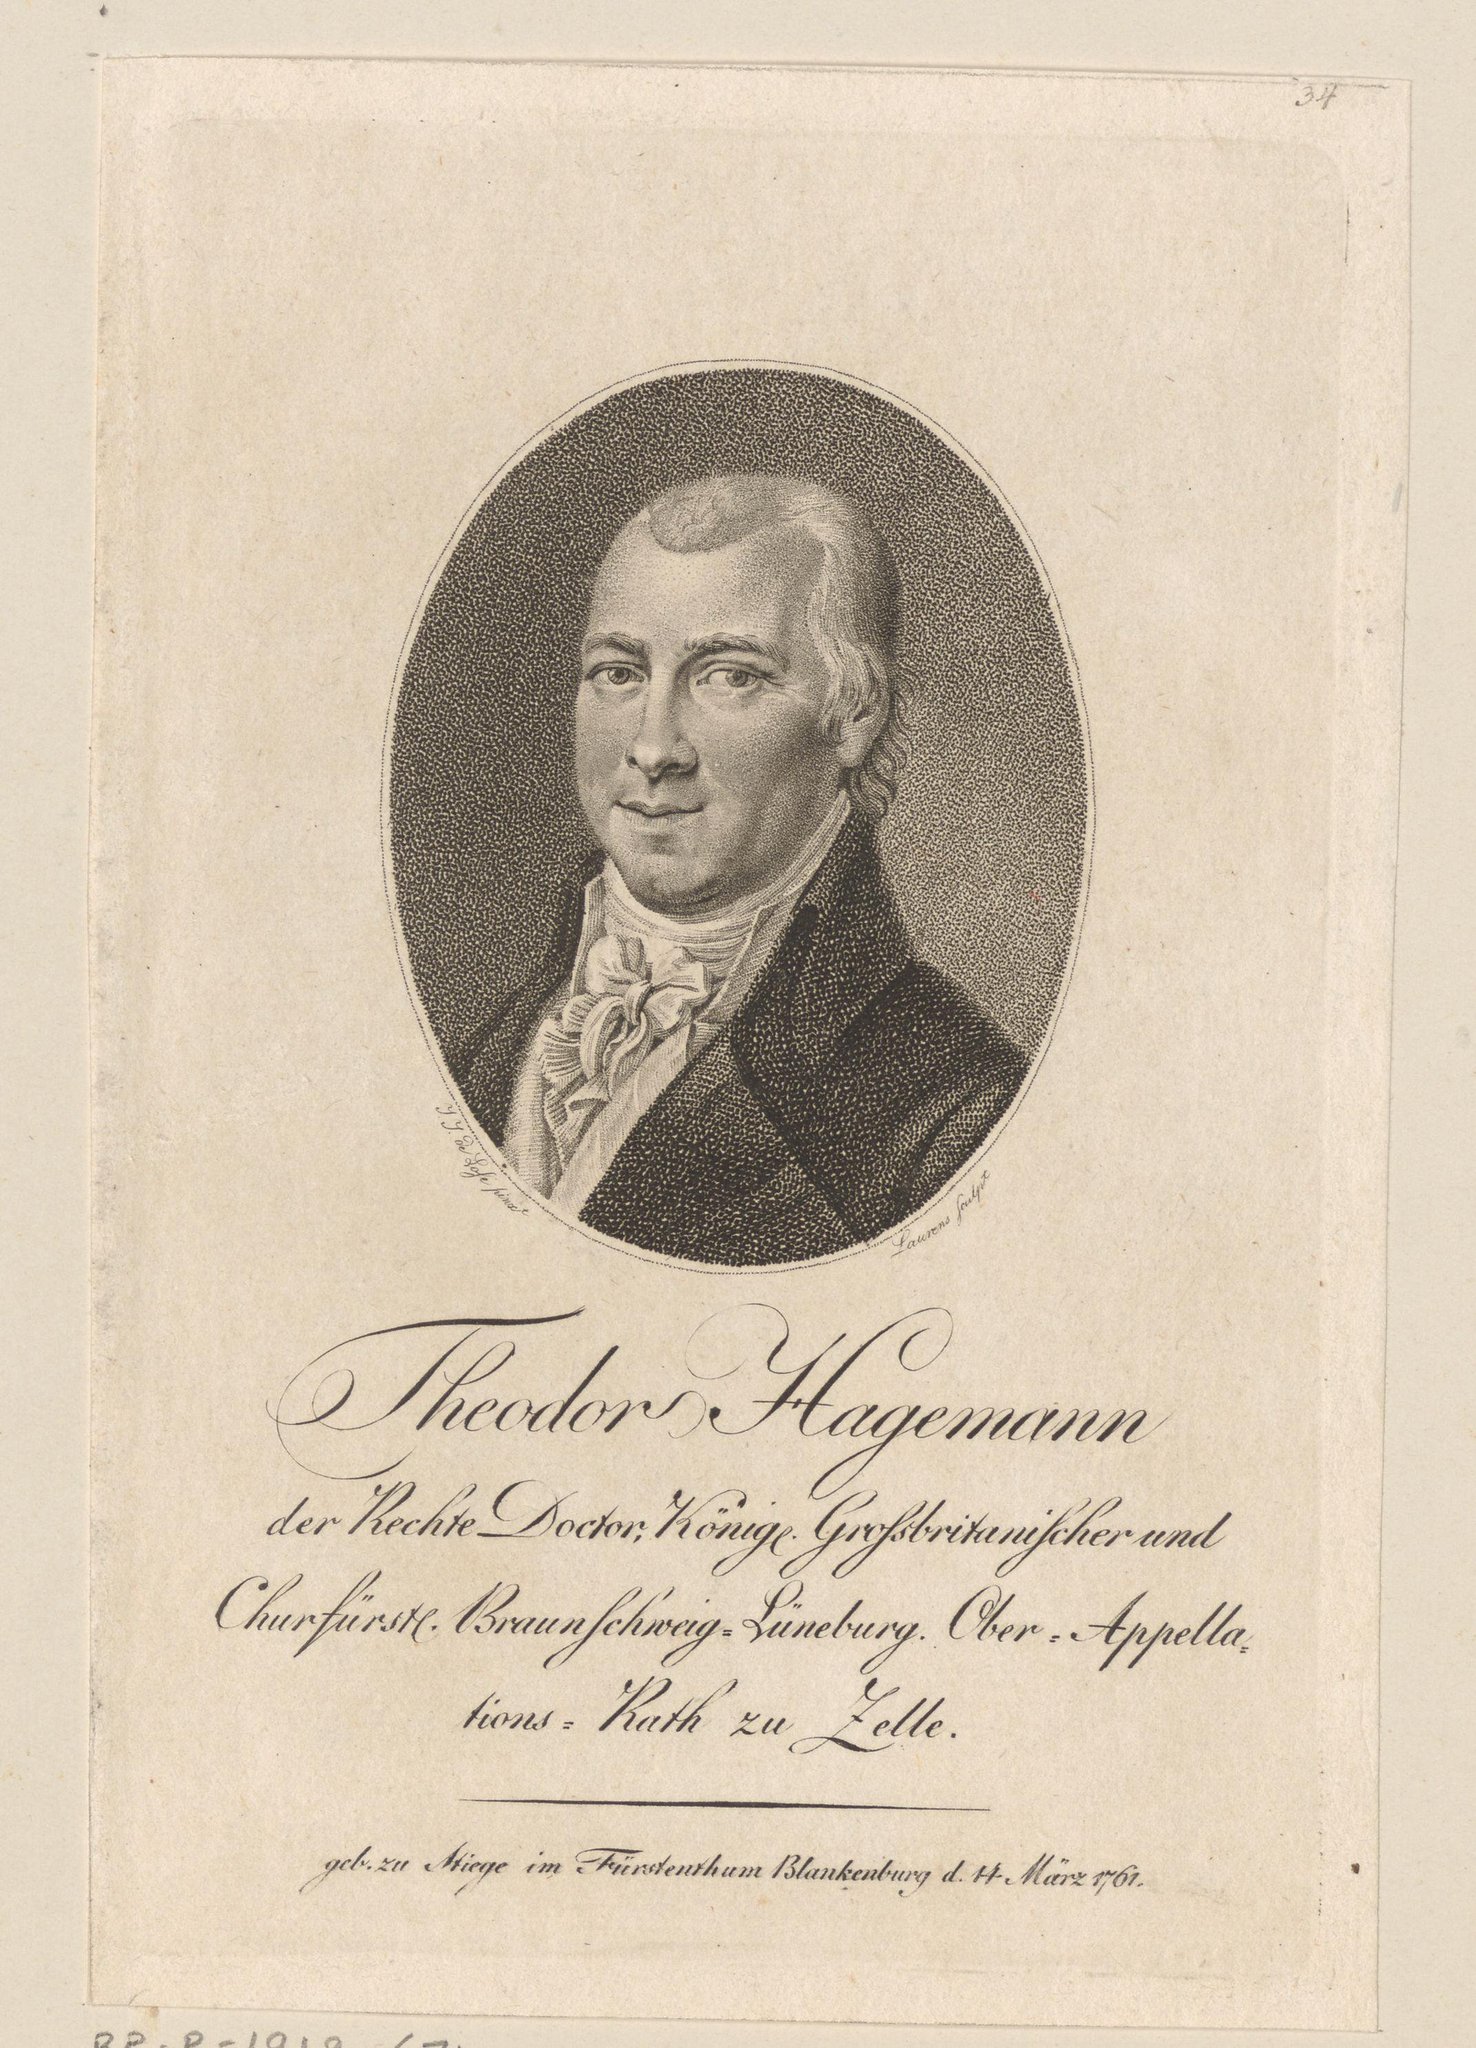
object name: print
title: Portret van Theodor Hagemann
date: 1780-1832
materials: paper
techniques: engraving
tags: historical persons, lawyer, attorney at law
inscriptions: collector's mark: Lugt 2233